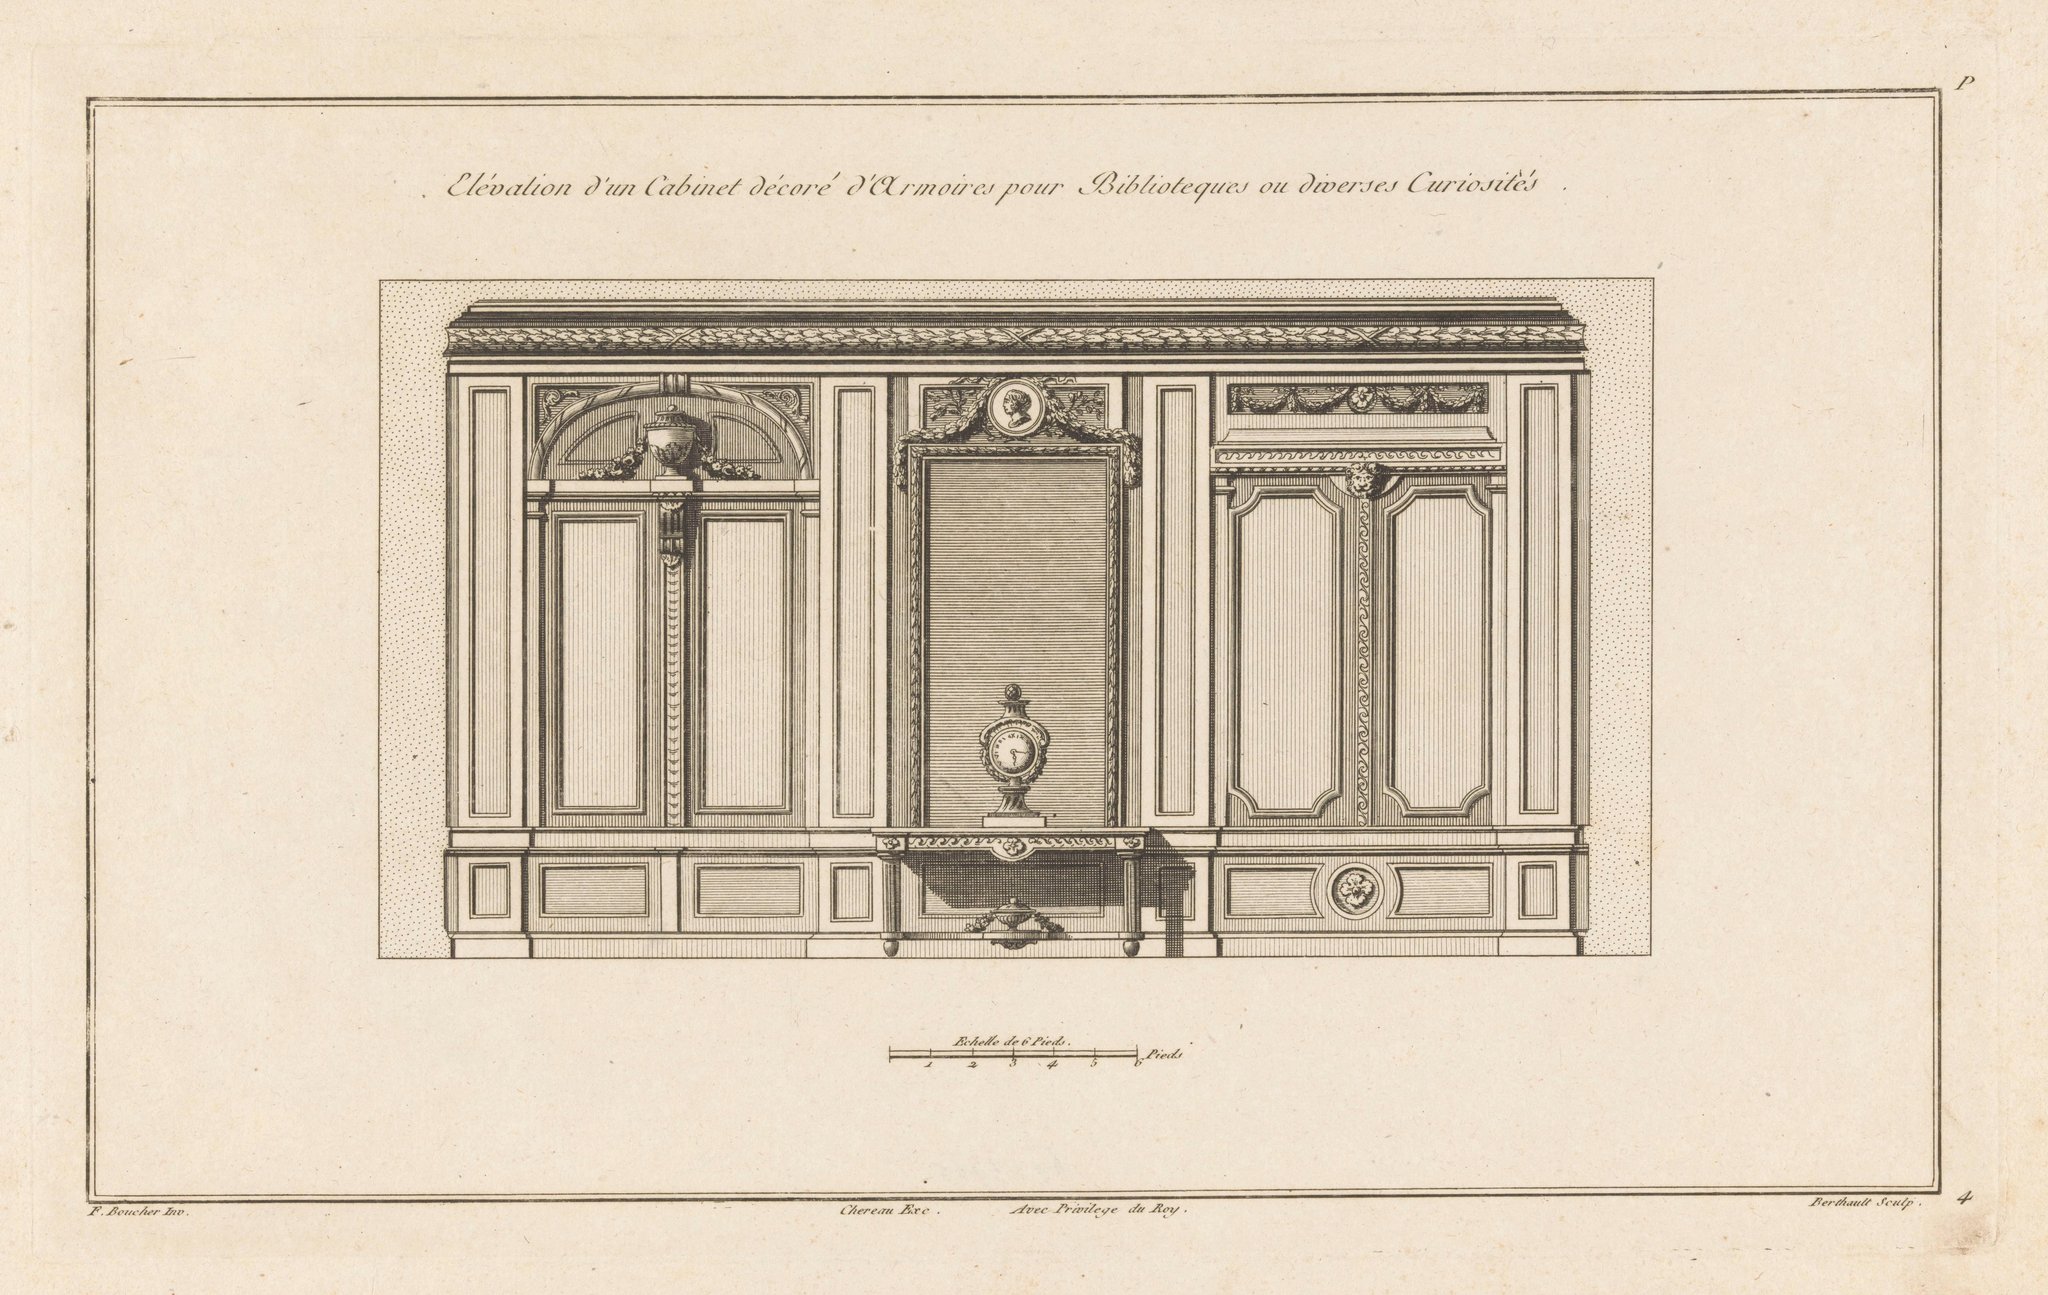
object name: ornament print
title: P Wandbetimmeringen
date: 1752-1794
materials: paper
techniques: engraving, etching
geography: paris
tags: decorations (interior of the house), furniture for storage, vase ~ ornament, table, clock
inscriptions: collector's mark: Lugt 2228, collector's mark: Lugt 2760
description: Een wandbetimmering met een tafel met klok geflankeerd door twee kasten, links met een vaas aan de bovenzijde.